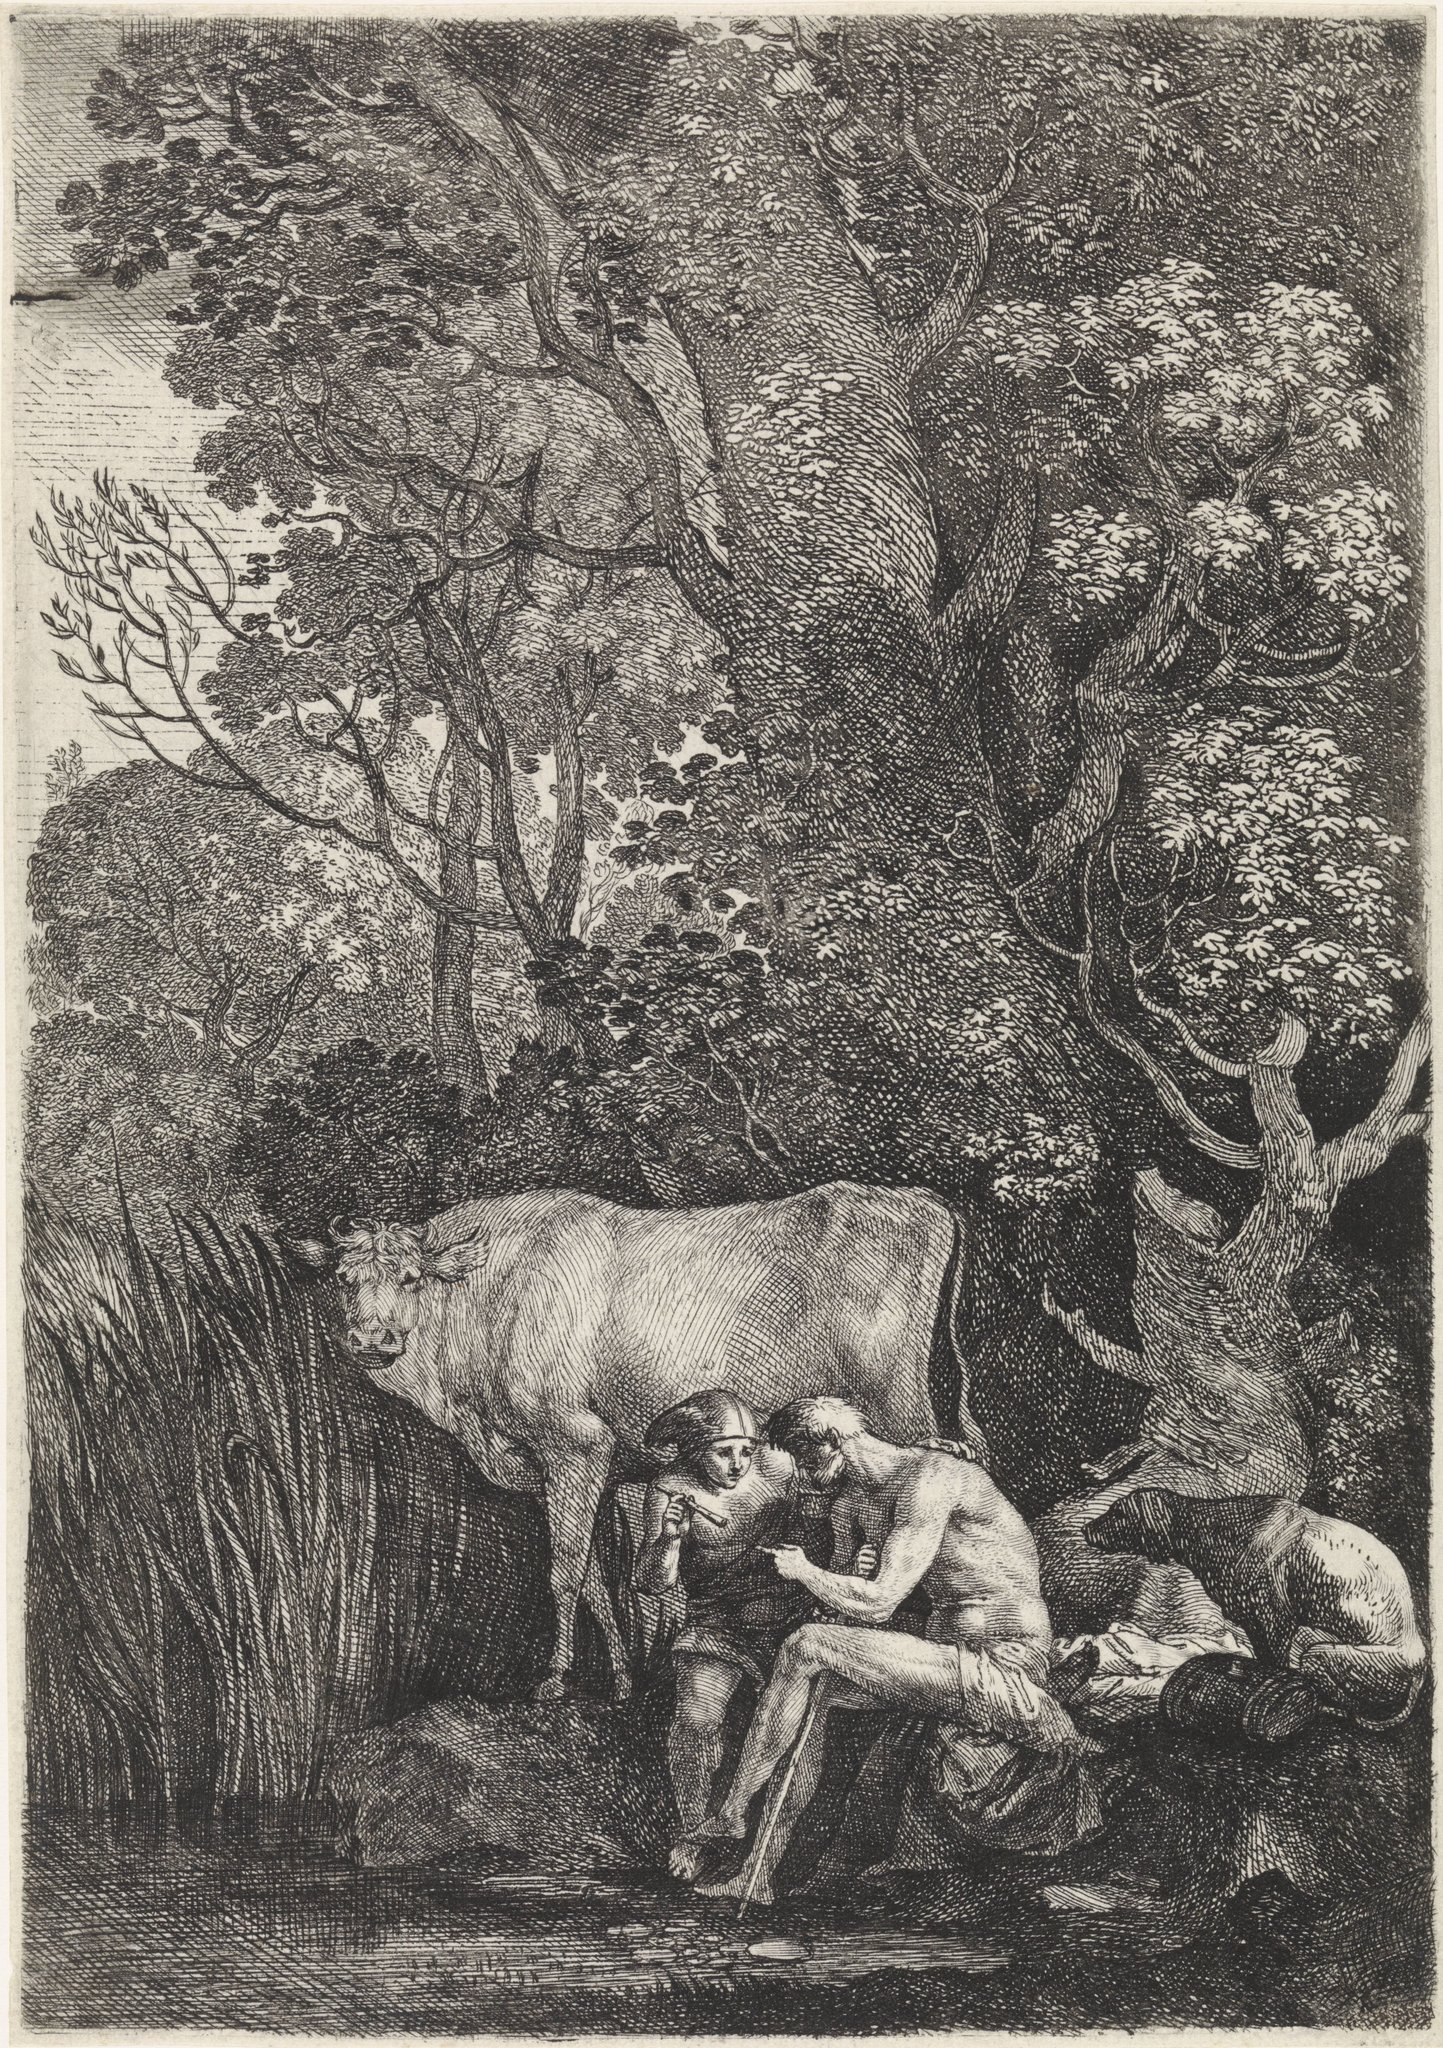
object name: print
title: Mercurius sust Argus in slaap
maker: moyses van wtenbrouck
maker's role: painter, print maker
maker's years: 1590-1647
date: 1600-1647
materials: paper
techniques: engraving, etching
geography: the hague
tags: mercury lulls argus into sleep by making music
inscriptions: collector's mark: Lugt 240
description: Mercurius is in gesprek met de reus Argus. Hij houdt zijn fluit in de hand. Achter Mercurius en Argus staat de koe Io. Scène uit Ovidius’ Metamorfosen (Met. I, 682-687).